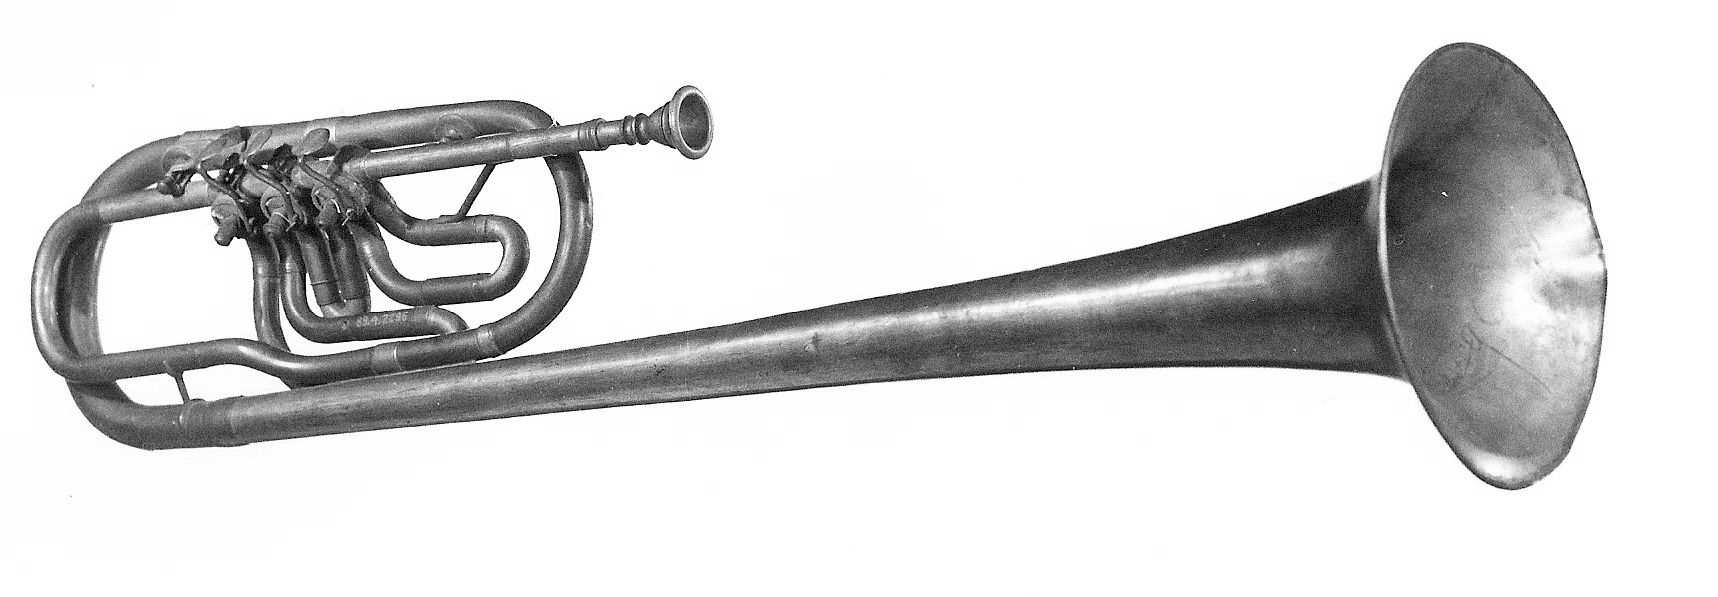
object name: alto saxhorn in e flat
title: Alto Saxhorn in E-flat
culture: european or american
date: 1834-1866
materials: brass, nickel, silver